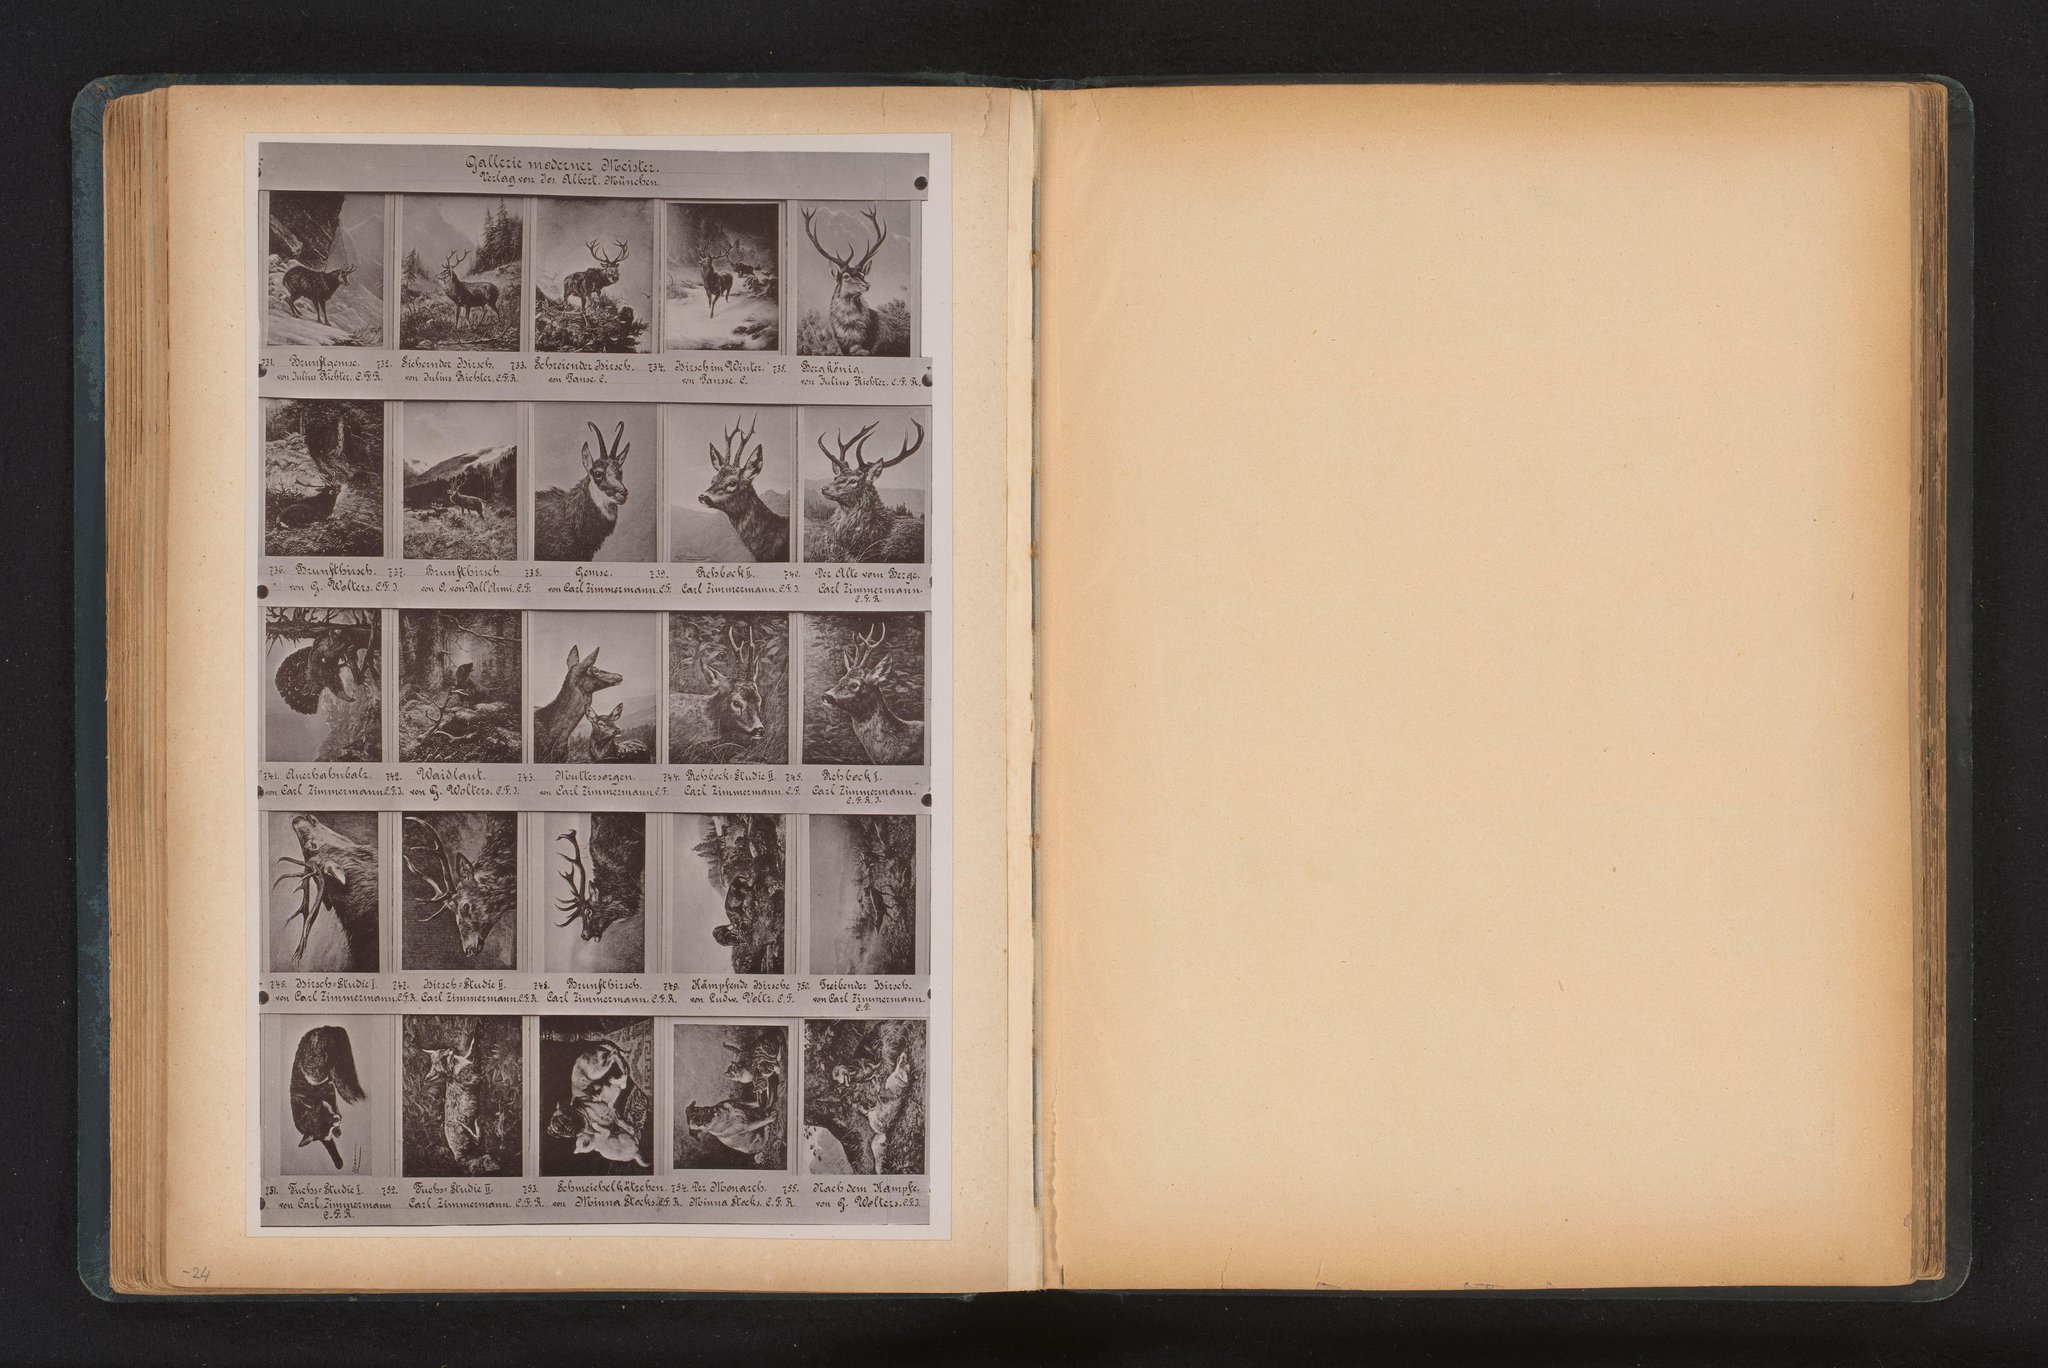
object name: reproduction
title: Gallerie moderner Meister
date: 1880-1885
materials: paper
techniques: photograph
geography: berlin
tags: hoofed animals: deer, predatory birds, fox and hounds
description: Prent op vierentwintigste ongenummerde pagina.